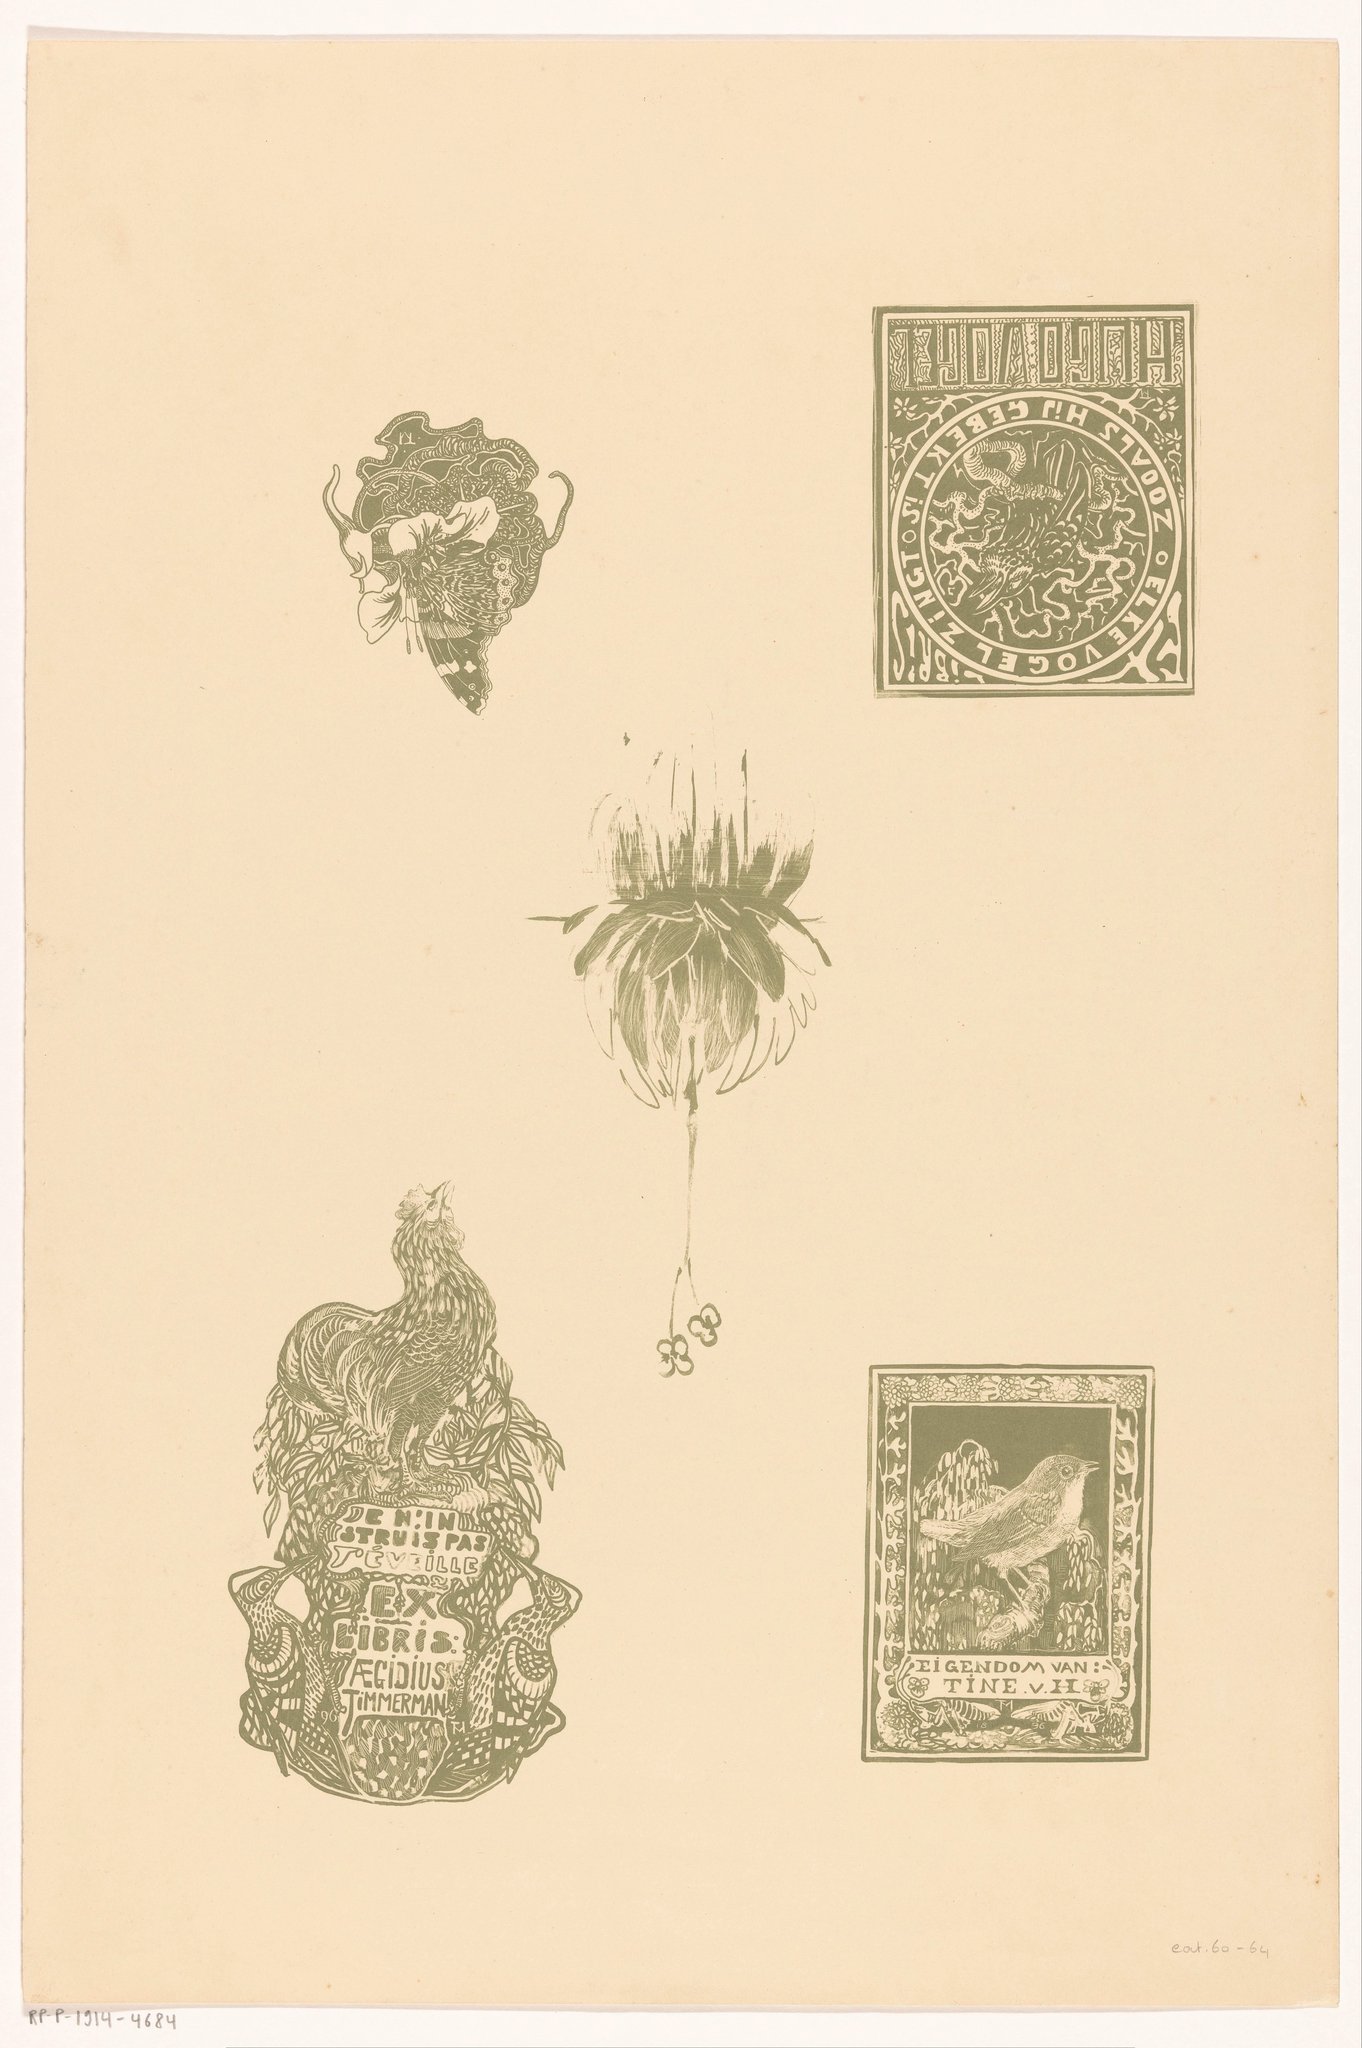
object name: print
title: Vijf voorstellingen met florale motieven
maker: theo van hoytema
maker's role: draughtsman, painter, print maker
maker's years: 1863-1917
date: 1896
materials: paper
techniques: lithograph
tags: aegidius willem timmerman, flowers, birds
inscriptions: collector's mark: Lugt 2233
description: Linksboven een vlinder op de bloem van een Oost-Indische kers. Rechtsboven een ex libris van Hugo Vogel met een vogel in een cirkel met de tekst 'Elke vogel zingt zooals hij gebekt is'. In het midden een waterlelie. Linksonder een ex libris van Aegidius Timmerman met een kraaiende haan boven twee spechten en de tekst 'Je n'instruis pas: J'eveille'. Rechtsonder een ex libris van Tine van Hoytema met een roodborst op een tak.